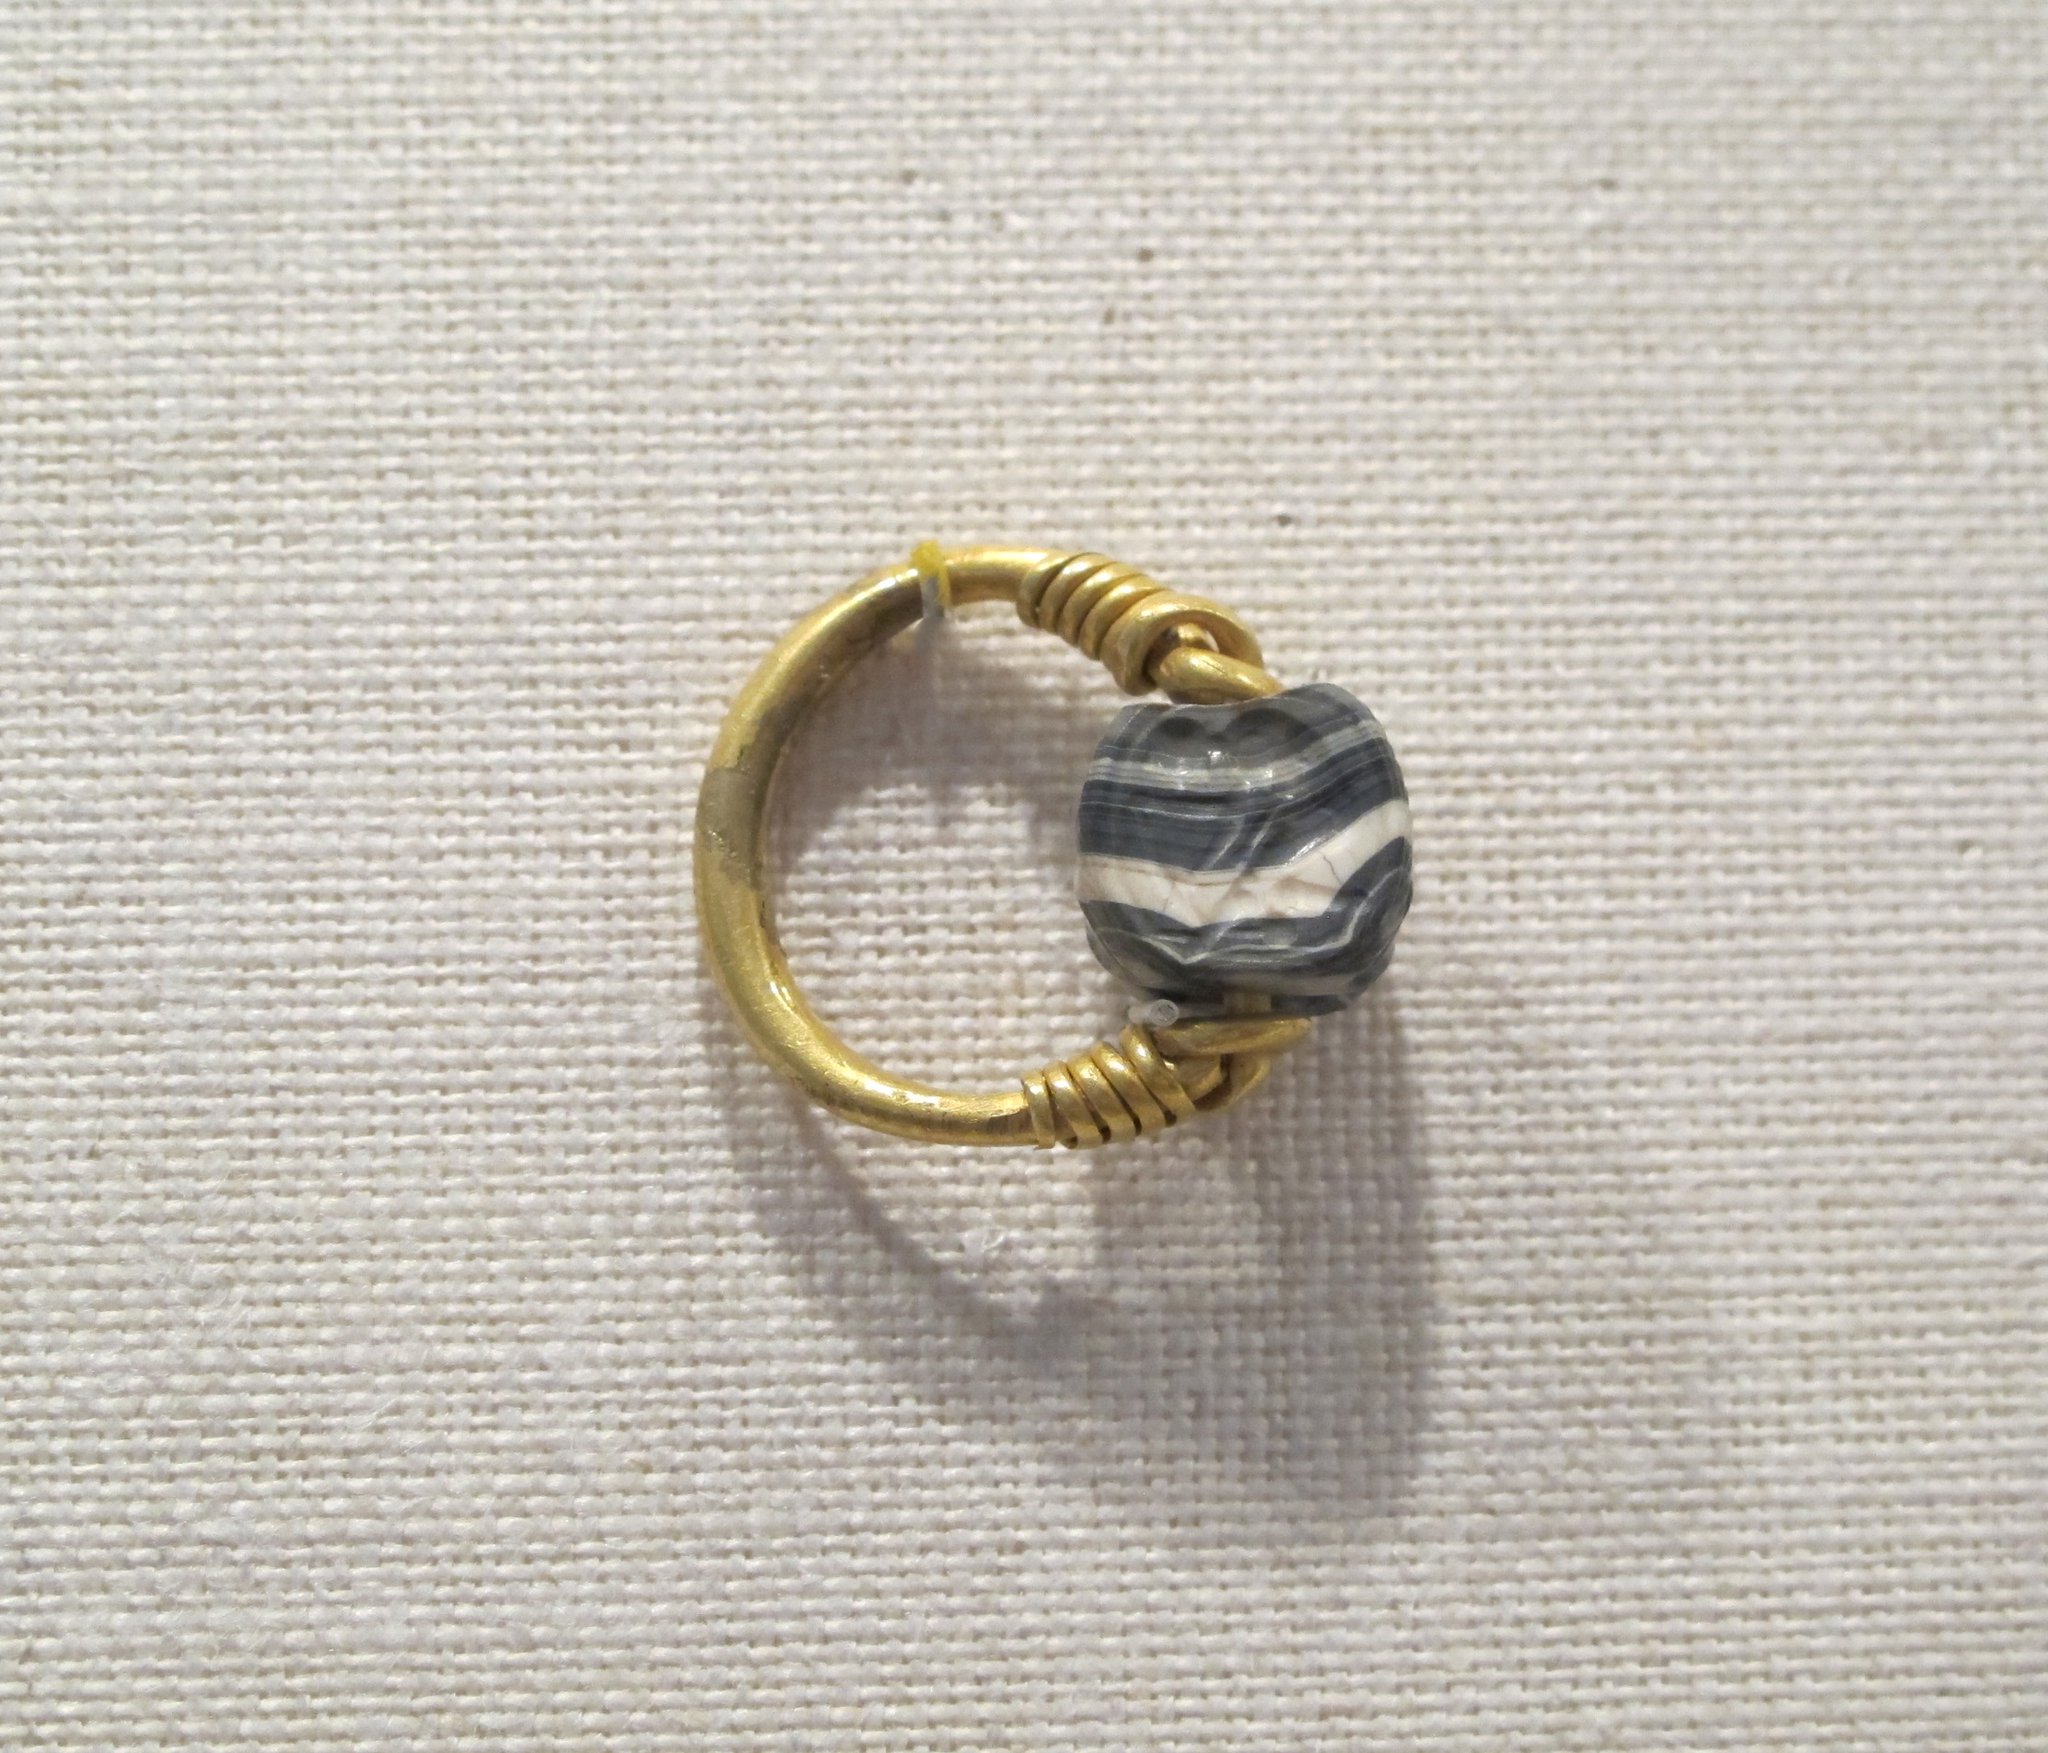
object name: intaglio in ring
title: Gold swivel ring with banded agate scarab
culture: etruscan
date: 400-301 BCE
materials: stone, gold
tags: men